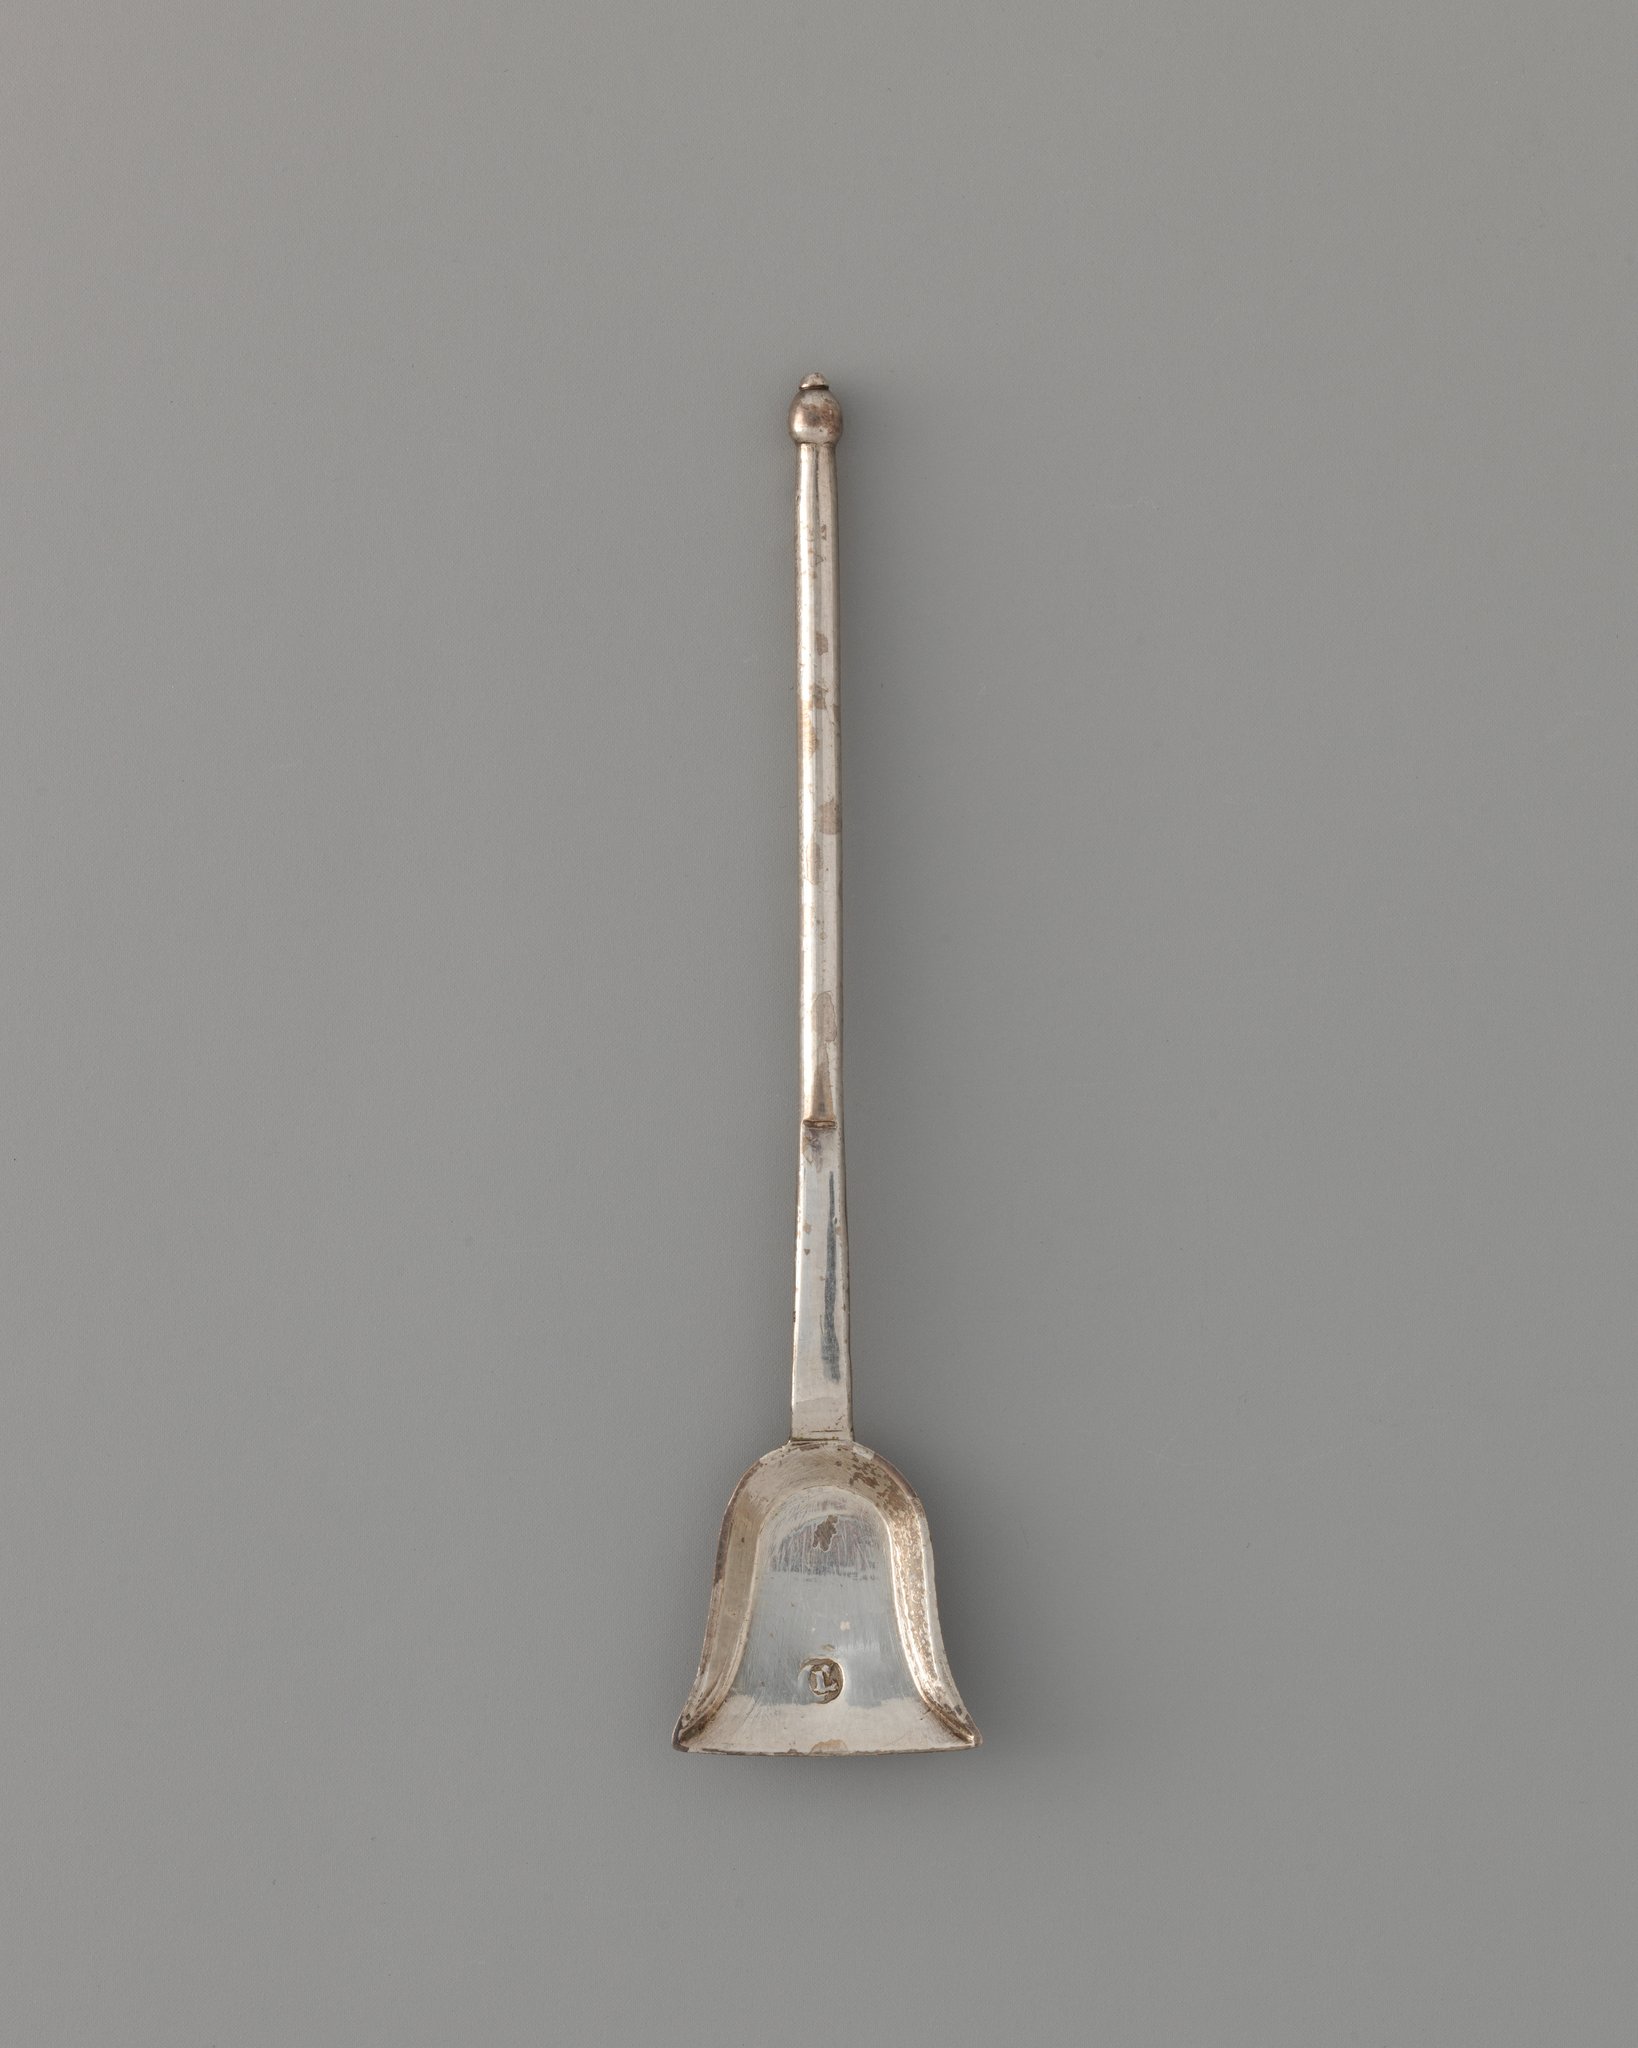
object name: shovel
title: Miniature shovel (part of a set)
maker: david clayton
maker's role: maker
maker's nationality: british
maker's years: 1659-1719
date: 1667-1733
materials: silver